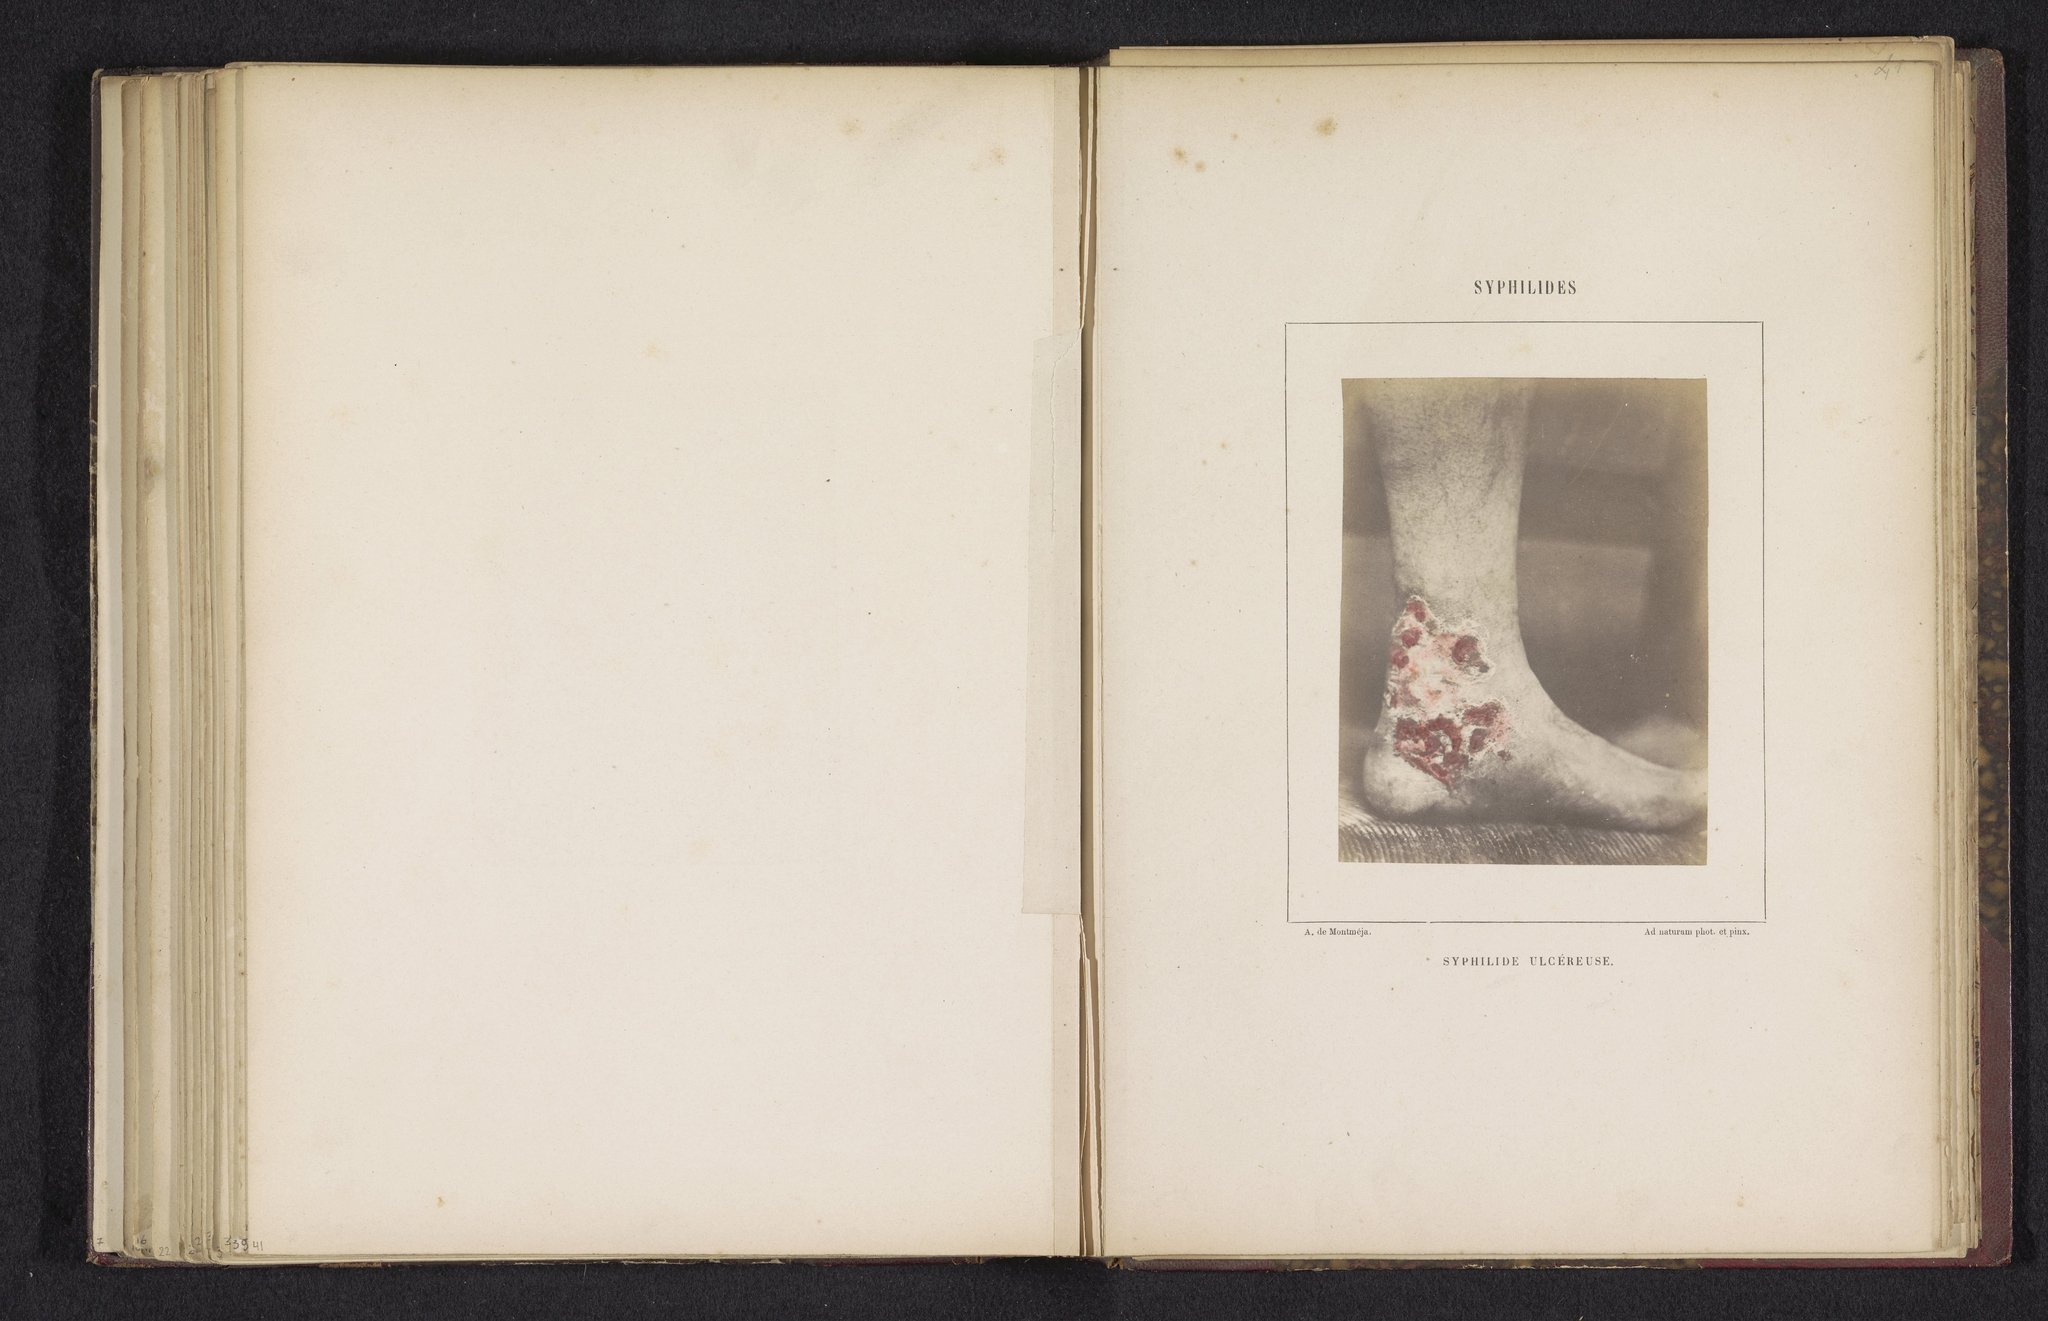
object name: page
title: Zwerende huiduitslag op een voet, veroorzaakt door syfilis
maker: a. de montméja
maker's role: arts, fotograaf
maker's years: 1841-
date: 1860-1868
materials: photographic support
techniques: albumen print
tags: skin and venereal diseases: syphilis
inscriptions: inscription: ‘Syphilides’, inscription: ‘Ad naturam phot. et pinx.’, number: ‘41’